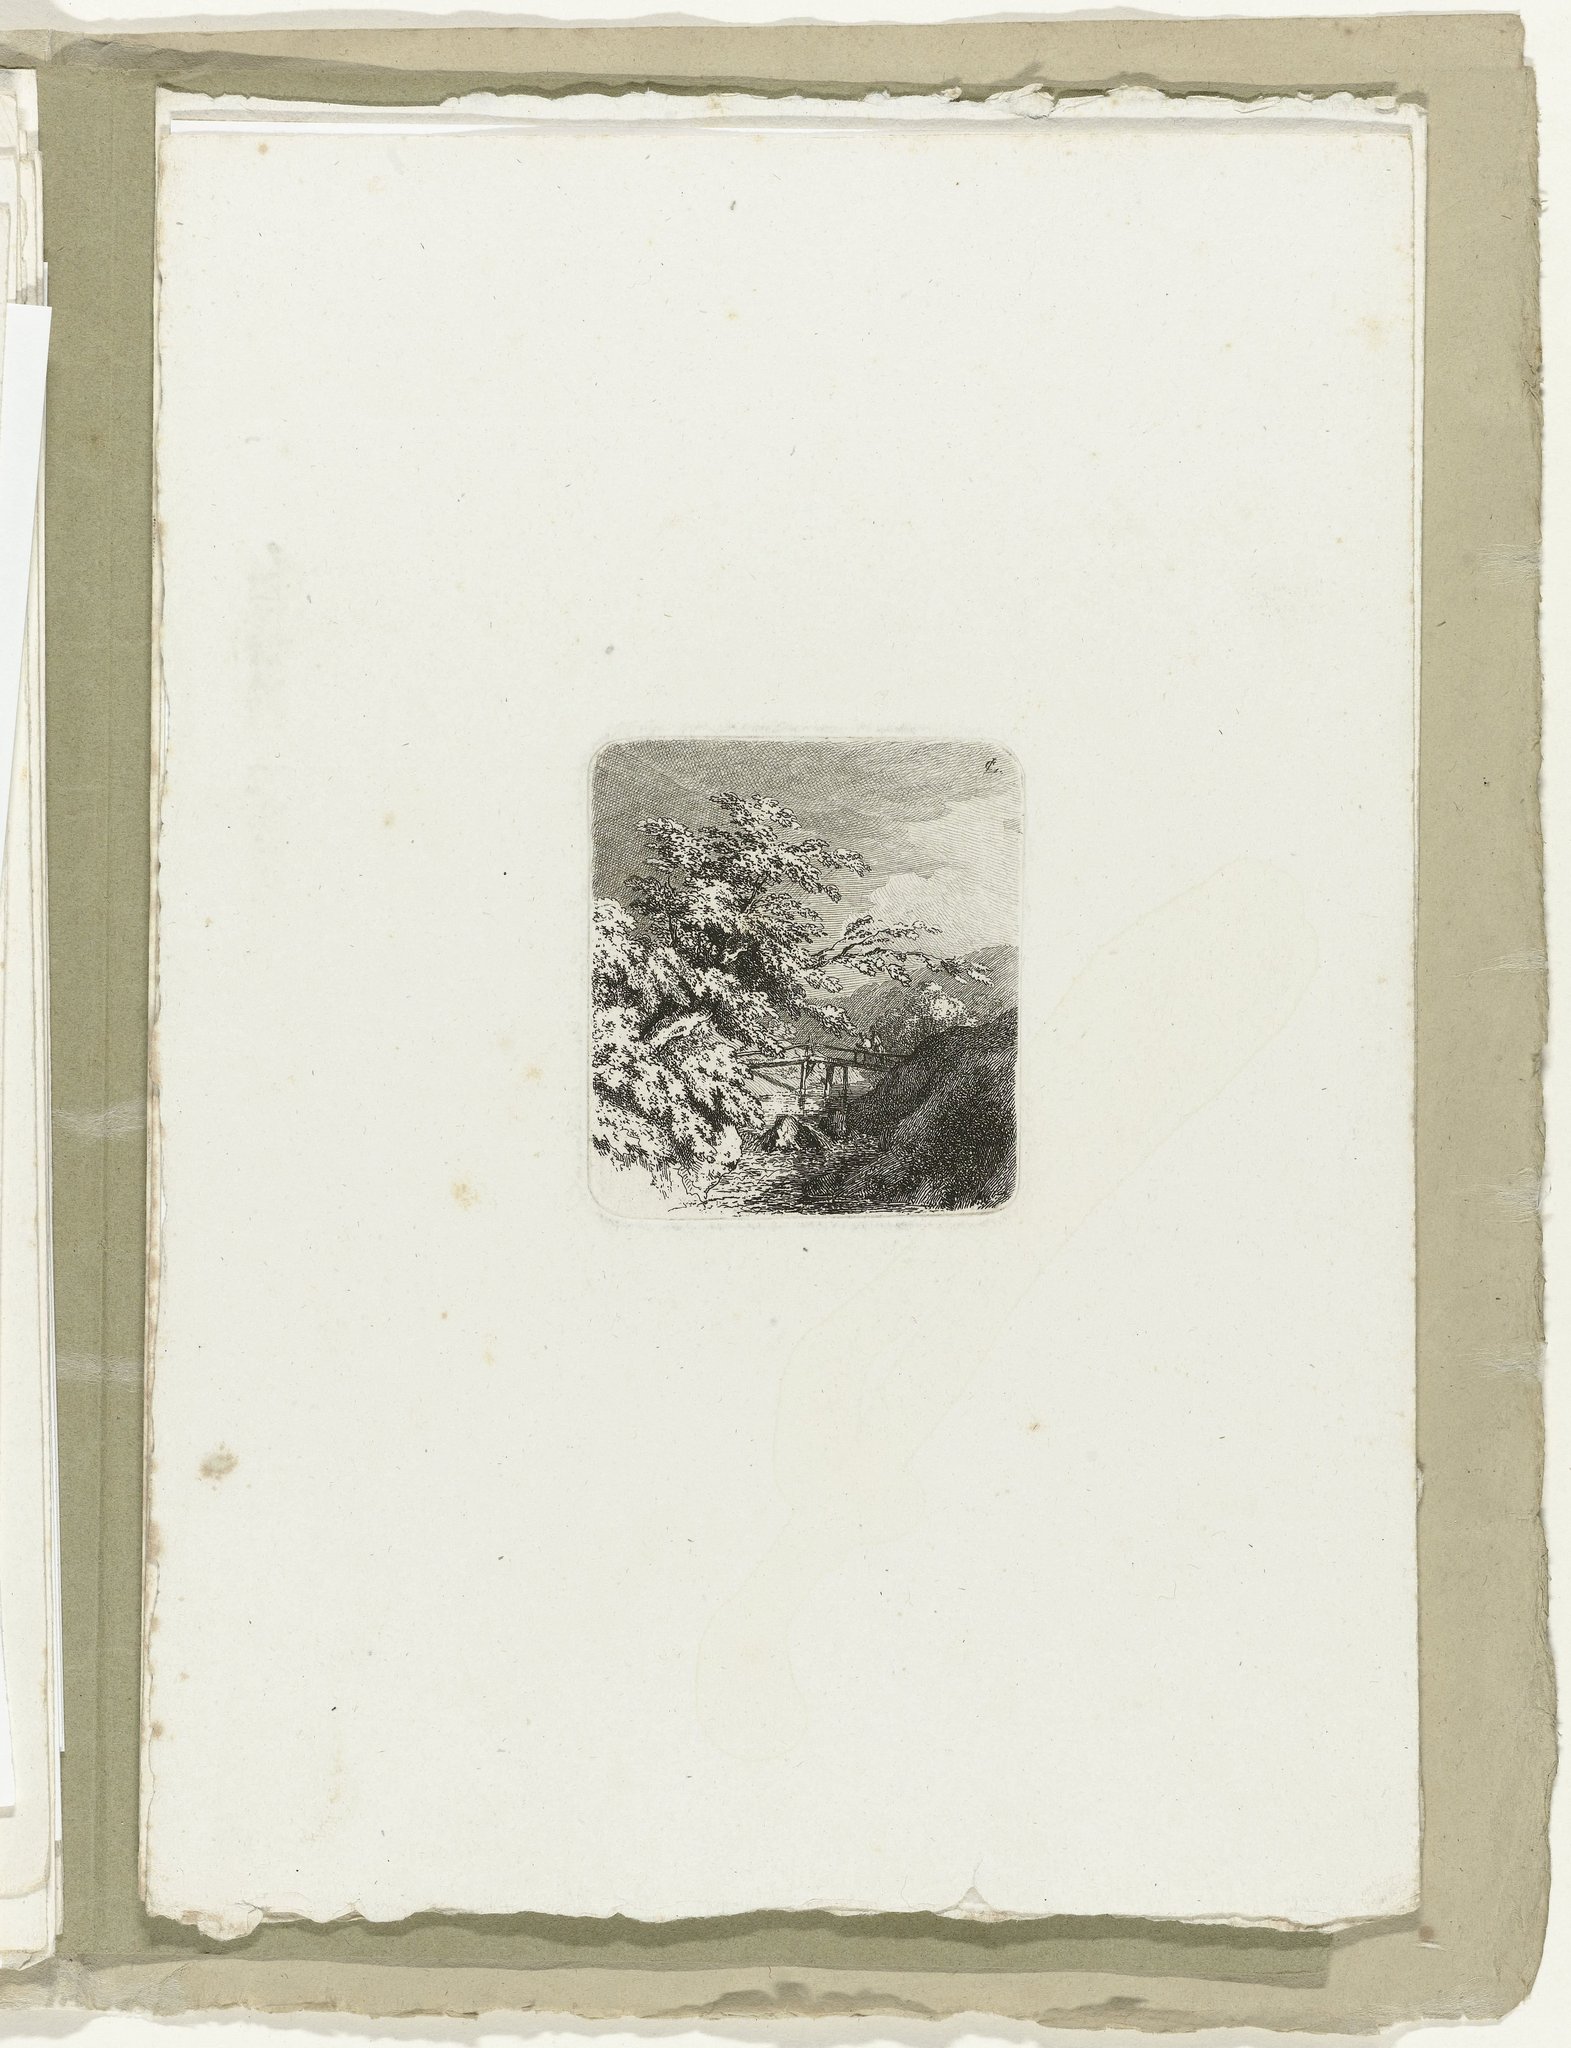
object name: print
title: Zestien landschappen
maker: carl august lebschee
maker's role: draughtsman, painter, print maker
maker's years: 1800-1877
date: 1827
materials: paper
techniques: etching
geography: munich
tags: landscape with bridge, viaduct or aqueduct (+ city(-scape) with figures, staffage)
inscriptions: signature: ‘CL’, collector's mark: Lugt 2228, collector's mark: Lugt 2760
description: Deze prent maakt deel uit van een dubbel omslag.